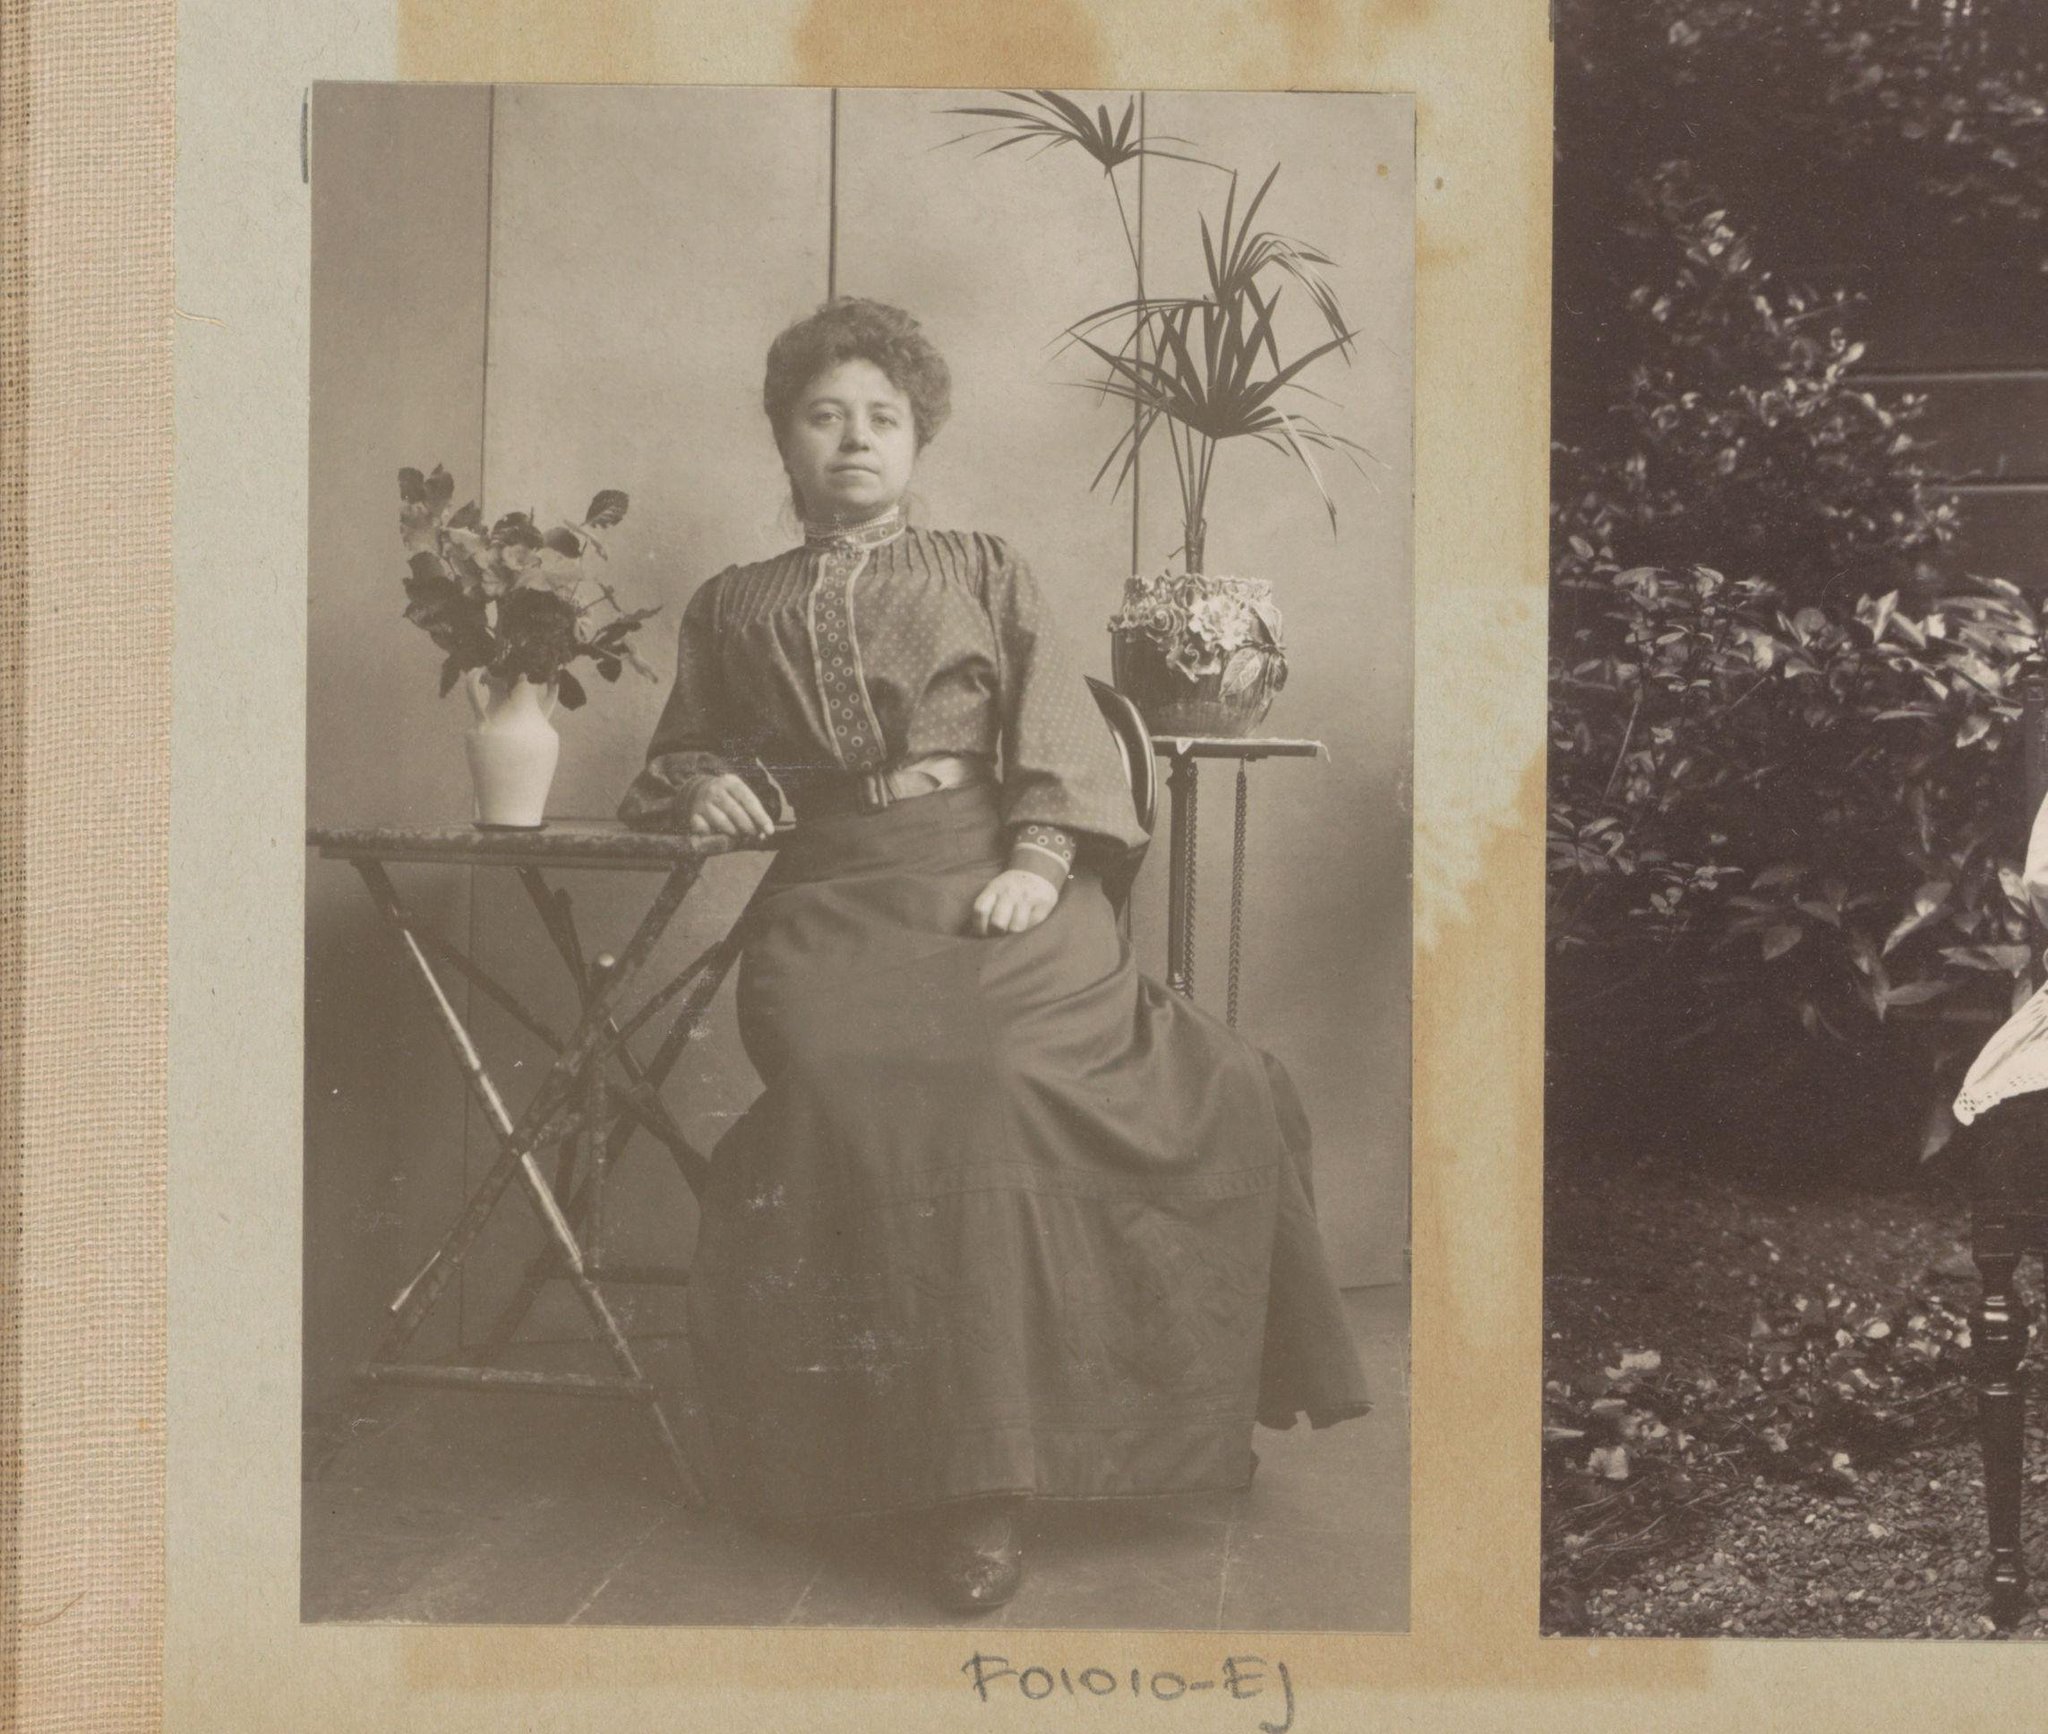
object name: photograph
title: Vrouw zittend bij tafels met een plant en bloemen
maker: Anonymous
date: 1900-1910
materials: photographic support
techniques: matte daylight collodion silver print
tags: plants; vegetation, cut flowers; nosegay, bunch of flowers, anonymous historical person portrayed - bb - woman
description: Onderdeel van Familiealbum met onder meer foto's van Wijnhandel Kraaij & Co. Bordeaux-Amsterdam.